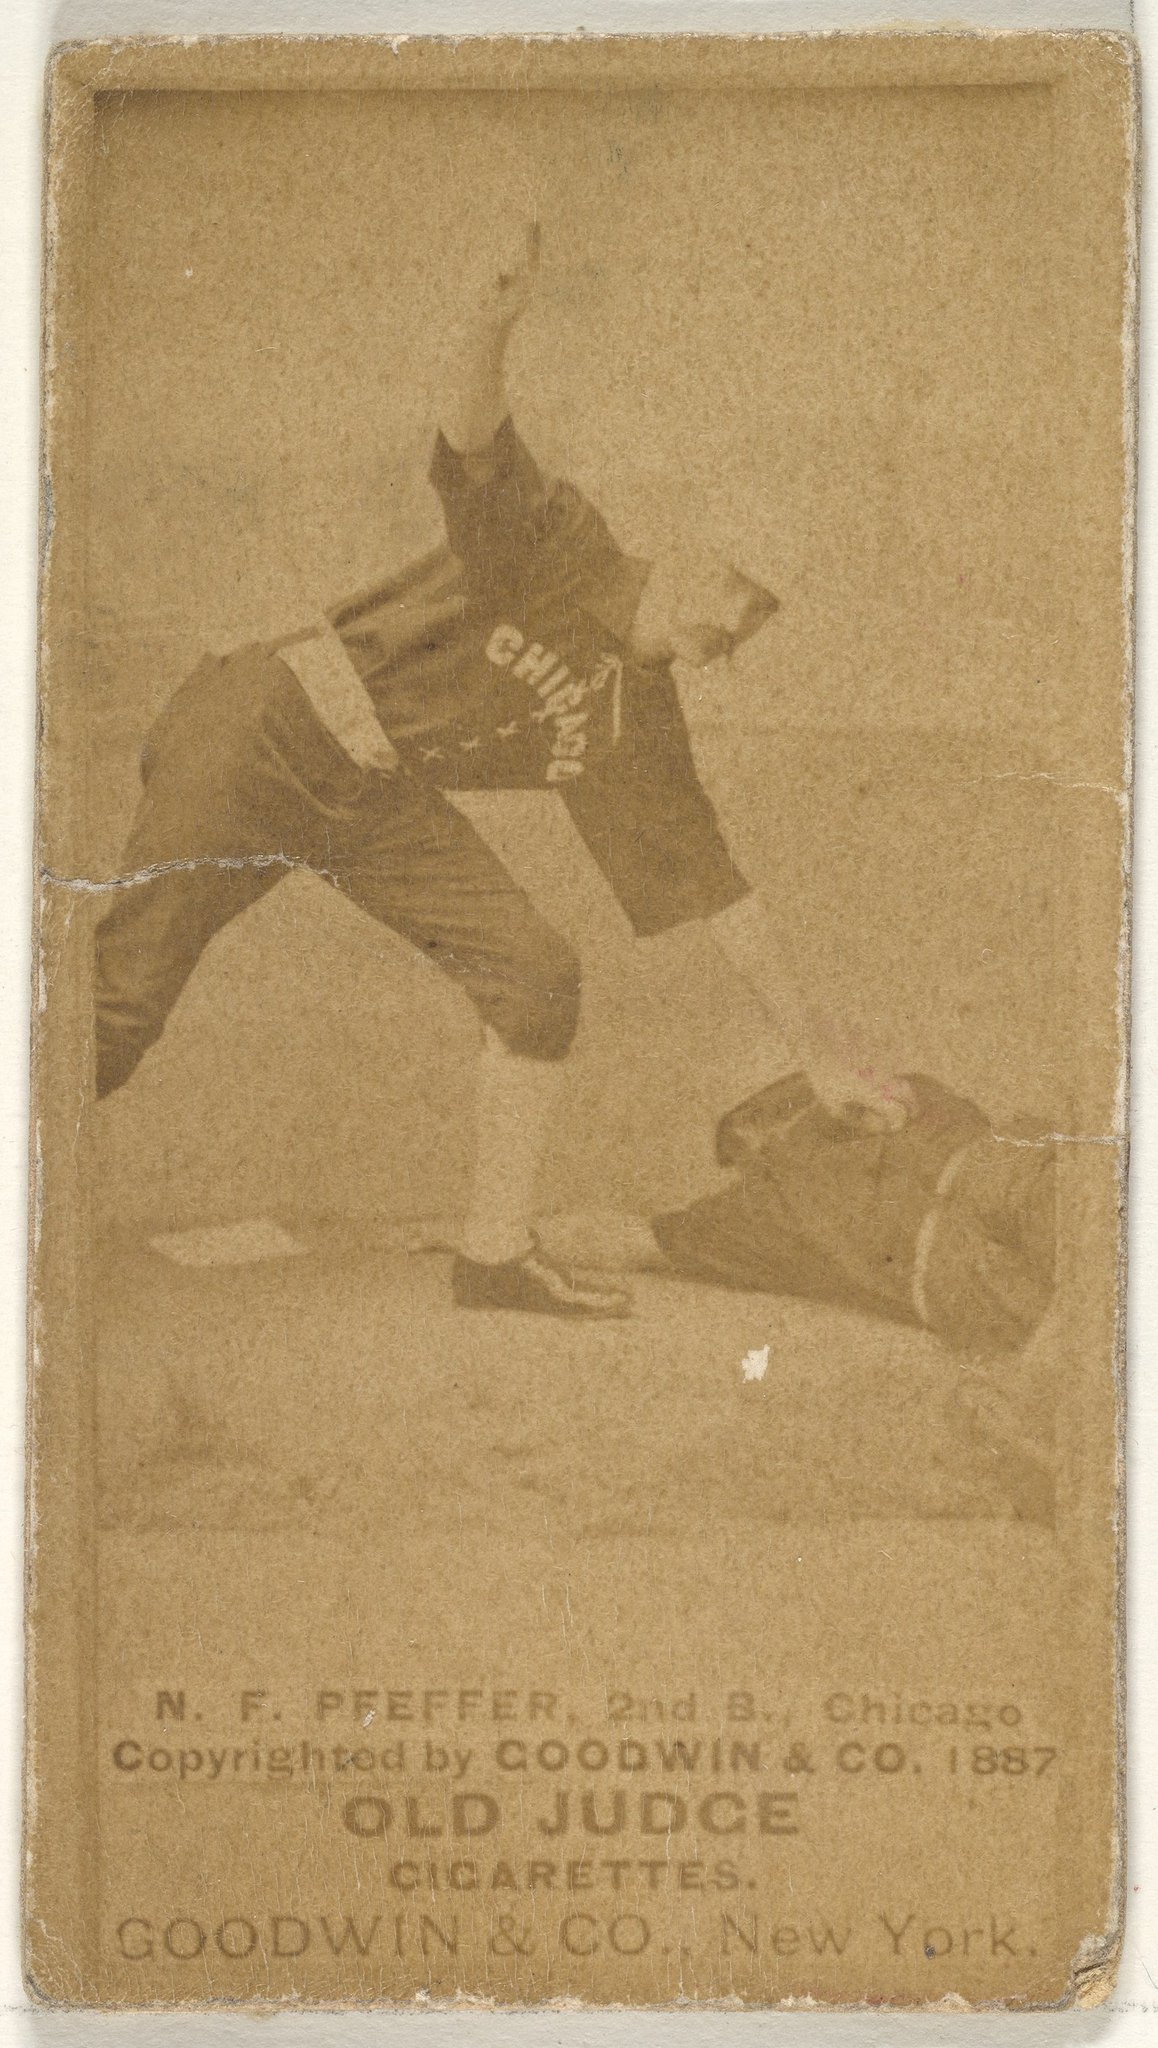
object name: baseball card, photograph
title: Fred "Dandelion" Pfeffer, 2nd Base, Chicago, from the Old Judge series (N172) for Old Judge Cigarettes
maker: goodwin & company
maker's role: publisher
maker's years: 1850-1950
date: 1887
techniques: albumen silver print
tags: men,portraits,baseball,athletes